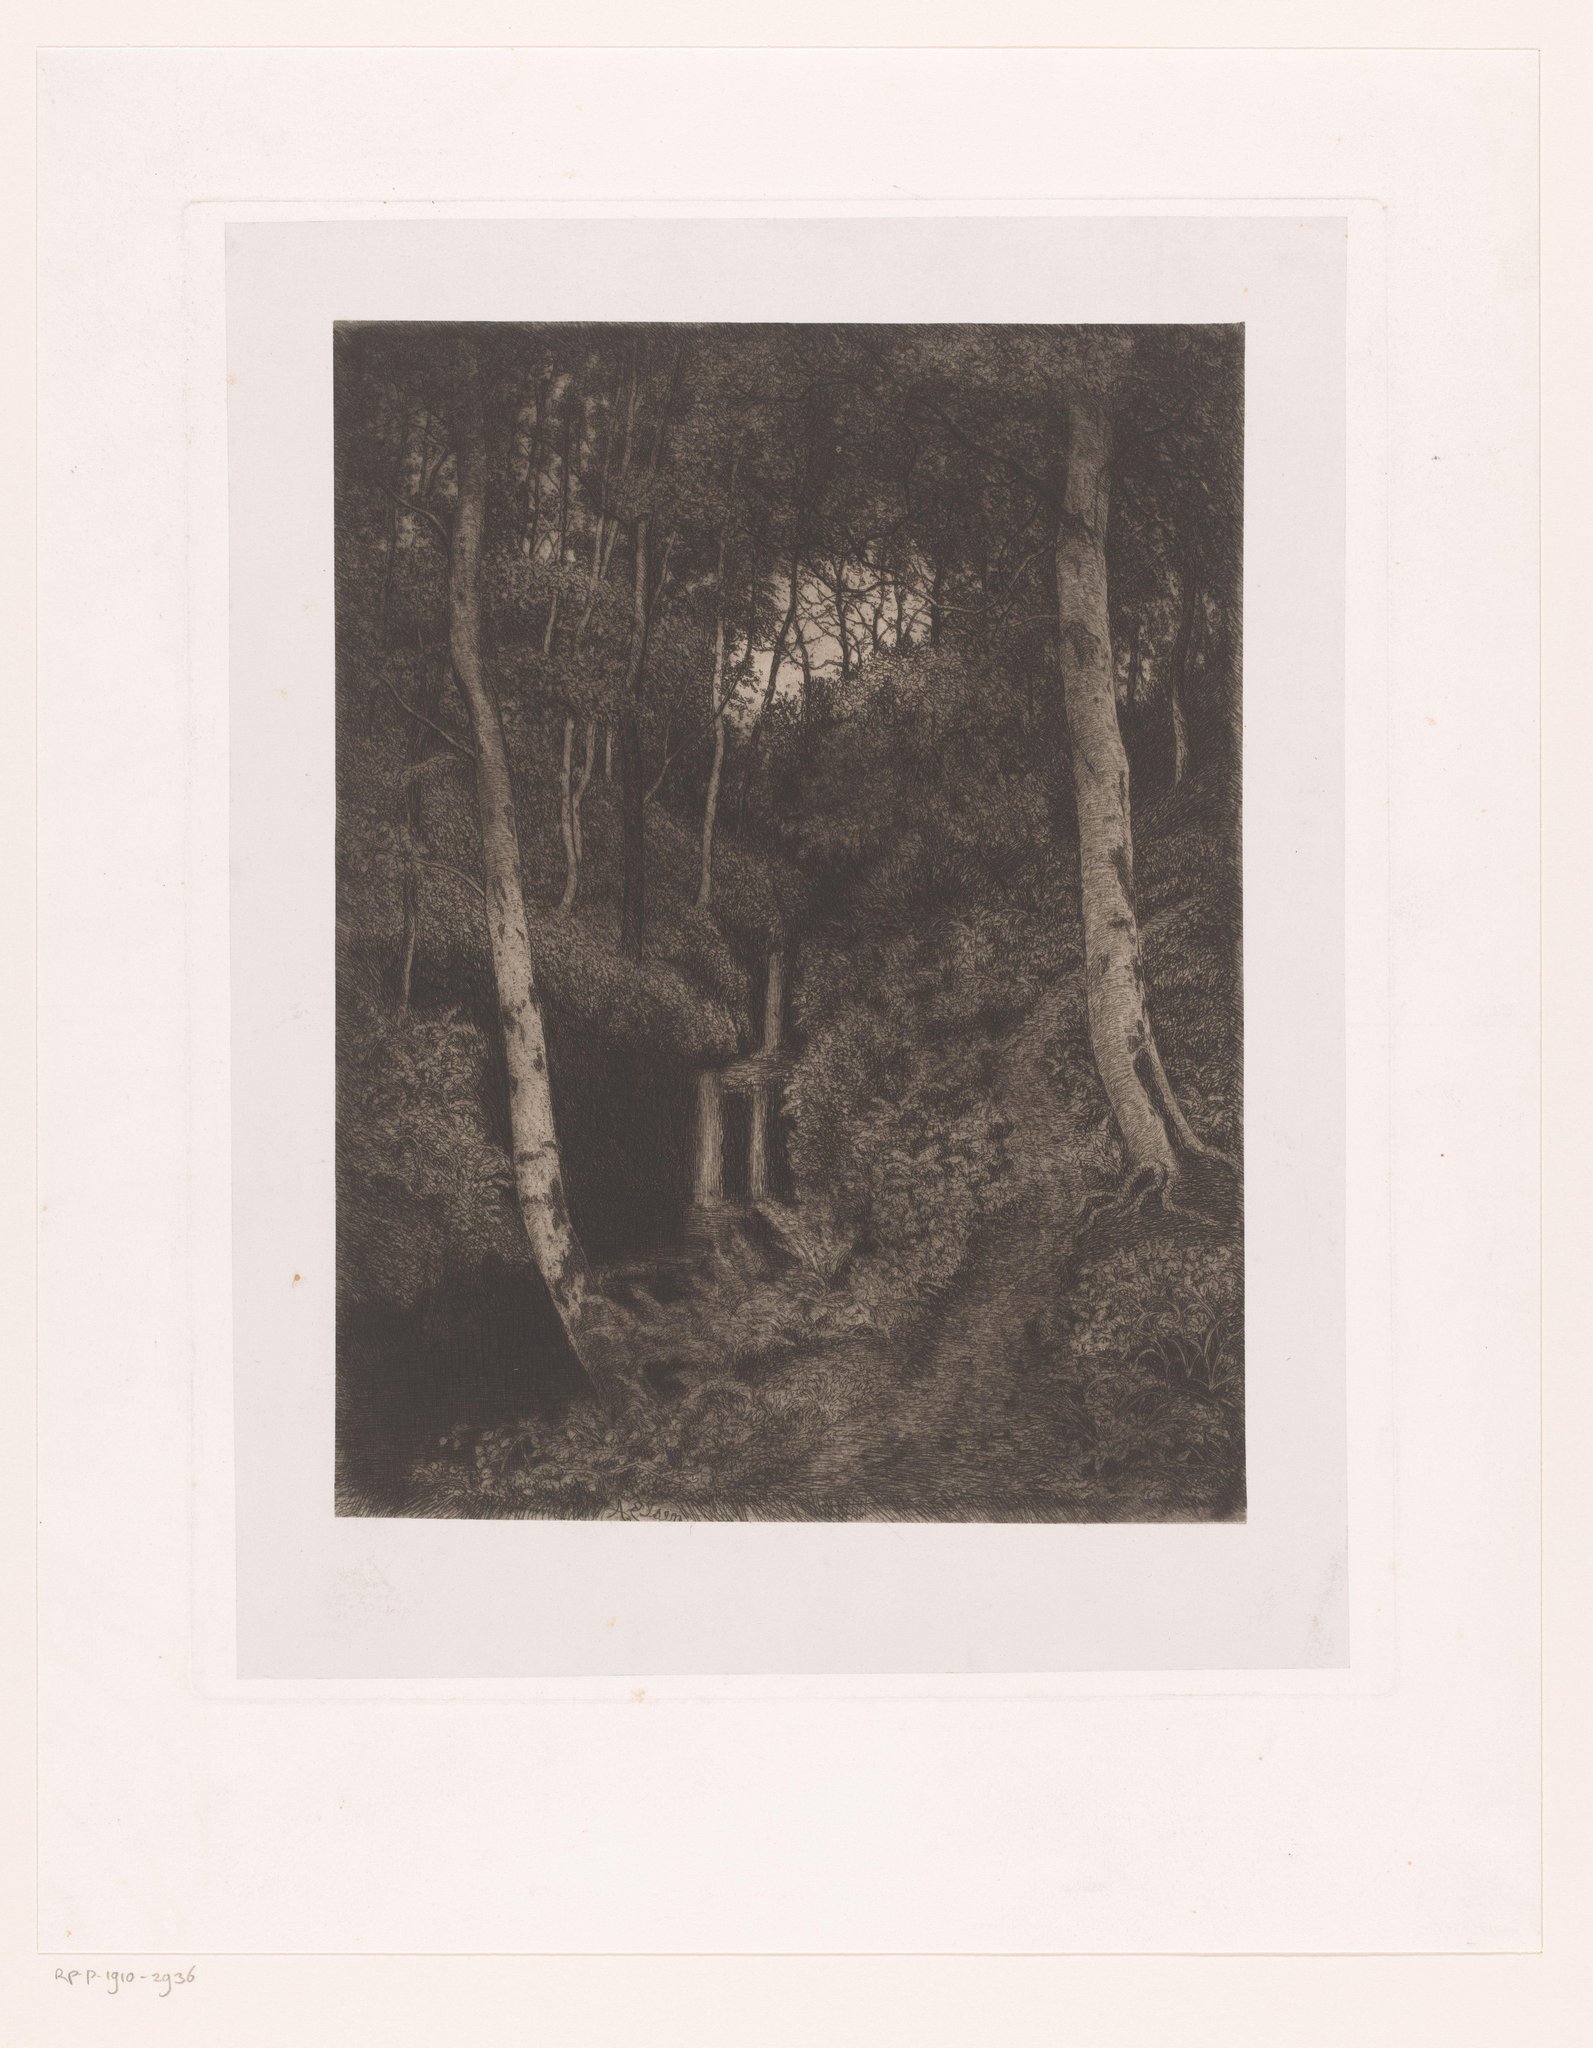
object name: print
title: Berkenbos met waterval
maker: alfred elsen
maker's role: painter, print maker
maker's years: 1850-1914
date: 1860-1910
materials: paper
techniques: etching, intaglio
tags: landscapes in the temperate zone, waterfall, trees: birch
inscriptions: collector's mark: Lugt 2228